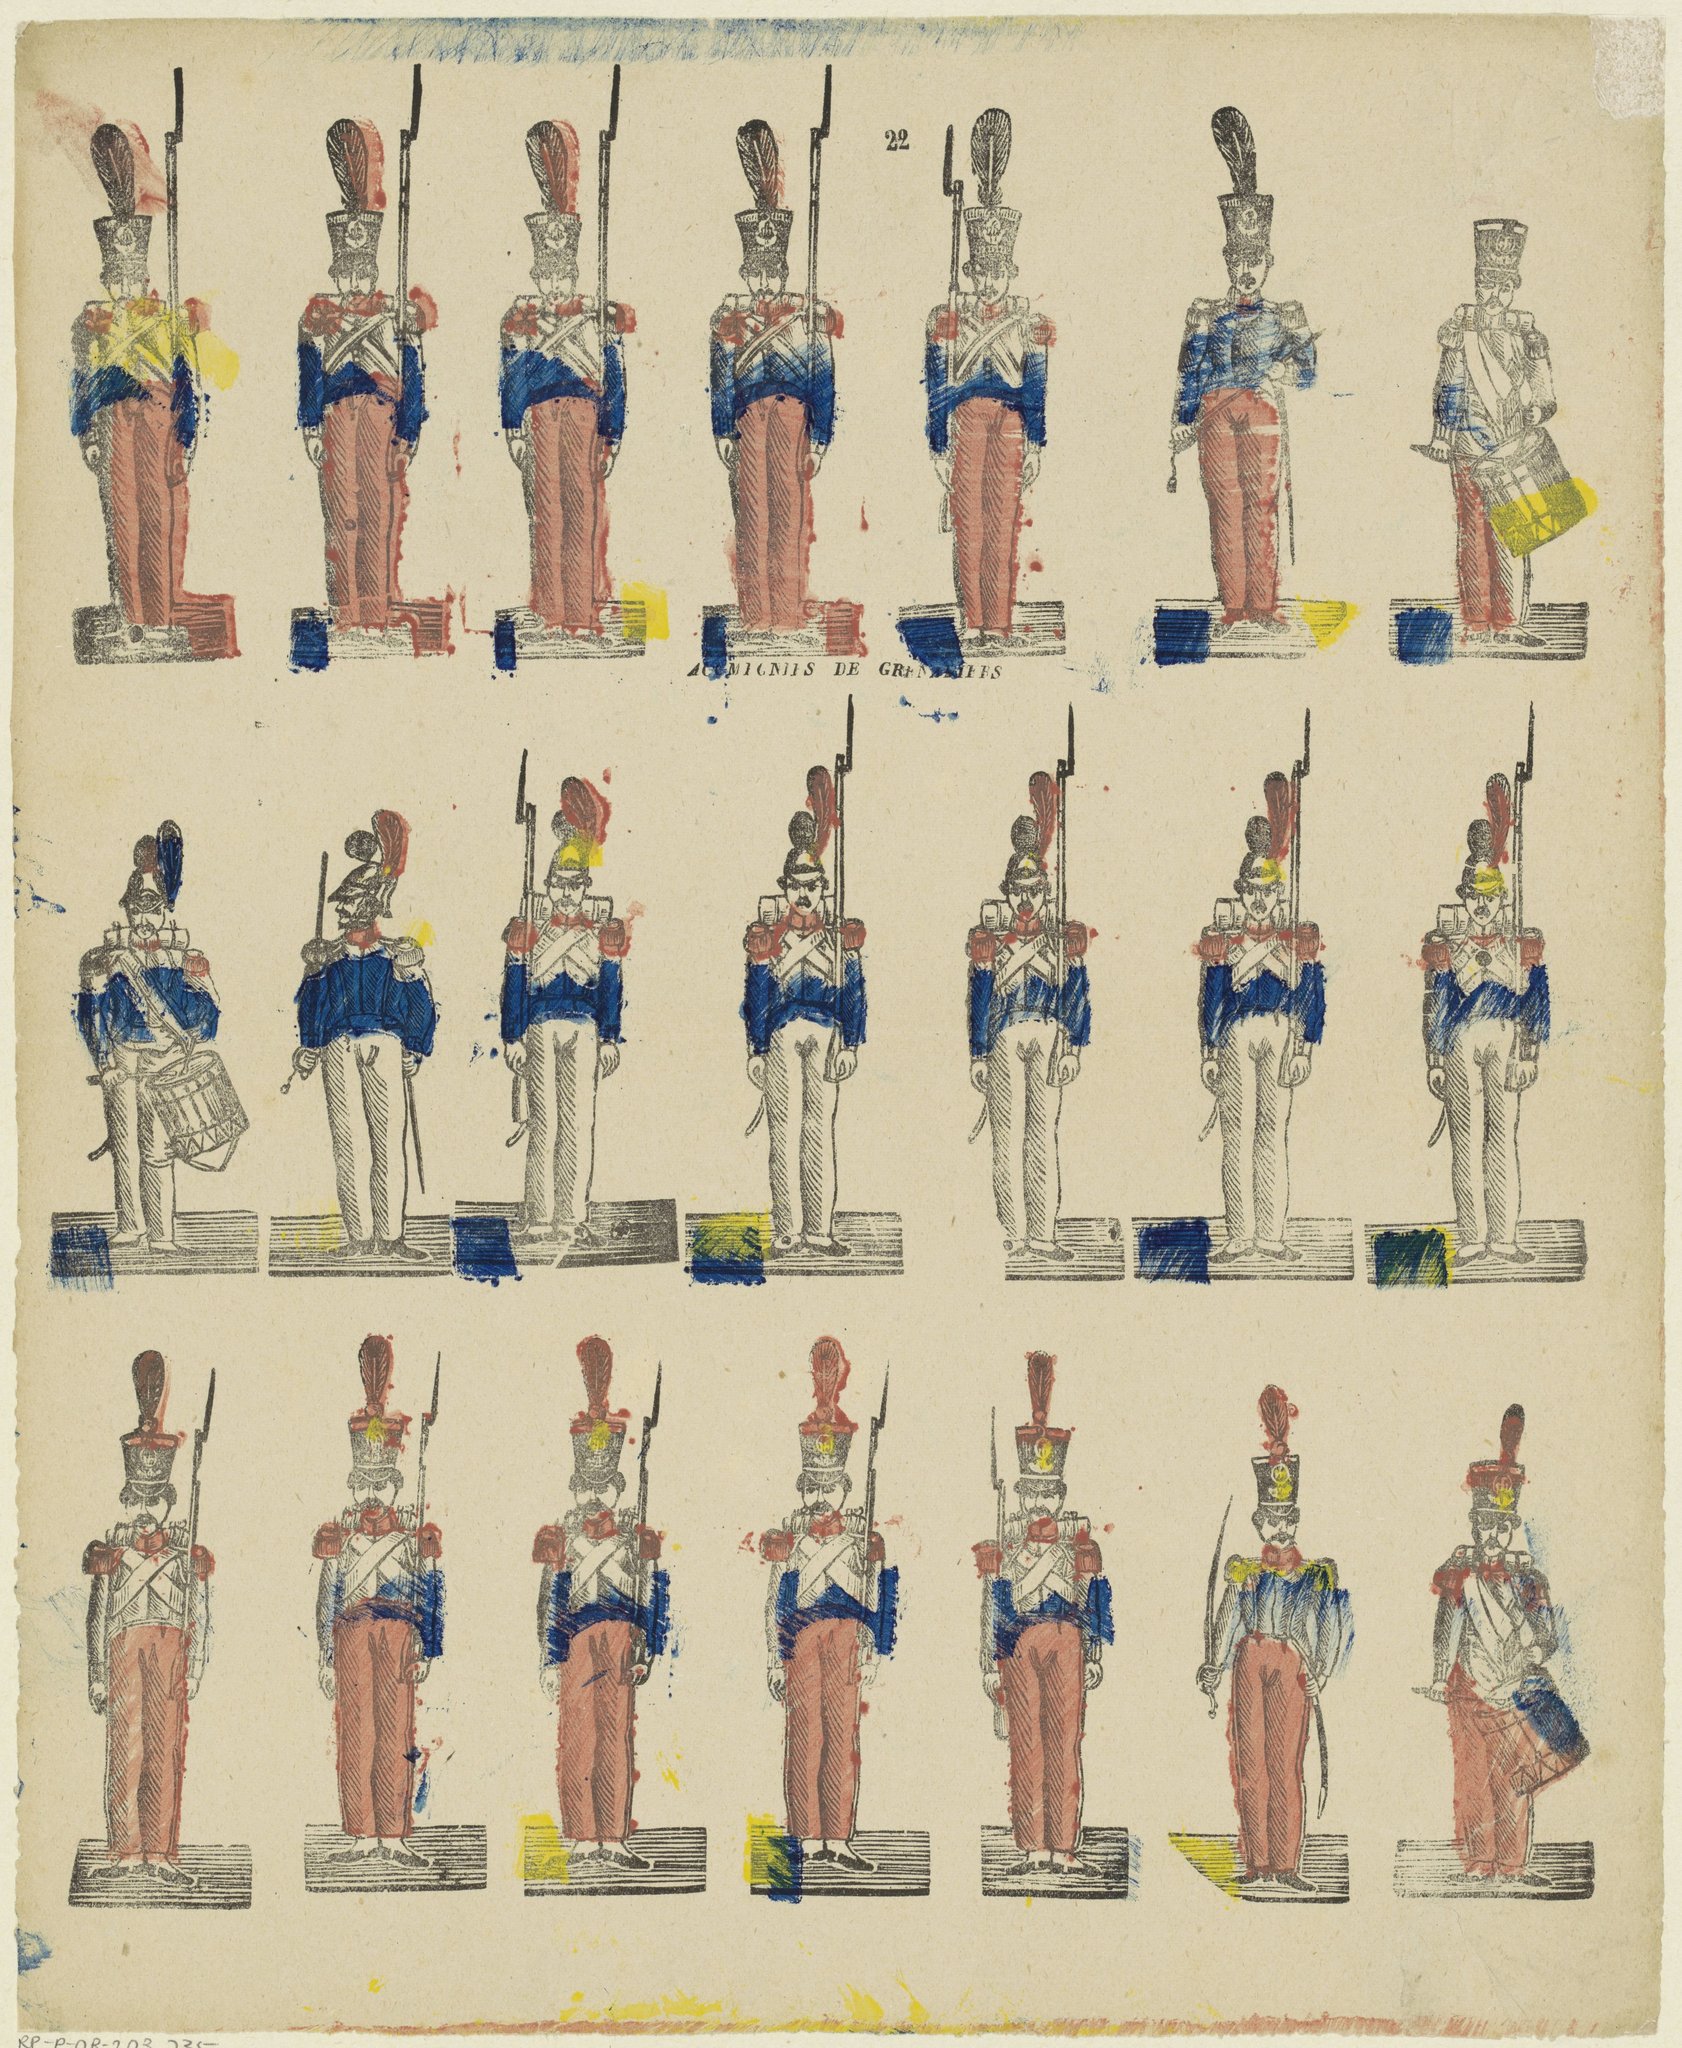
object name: print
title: Militairen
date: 1827-1894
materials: paper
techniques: colour, letterpress printing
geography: schaarbeek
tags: the soldier; the soldier's life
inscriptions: collector's mark: Lugt 2760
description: Blad met 21 voorstellingen van militairen. Genummerd midden boven: 22.